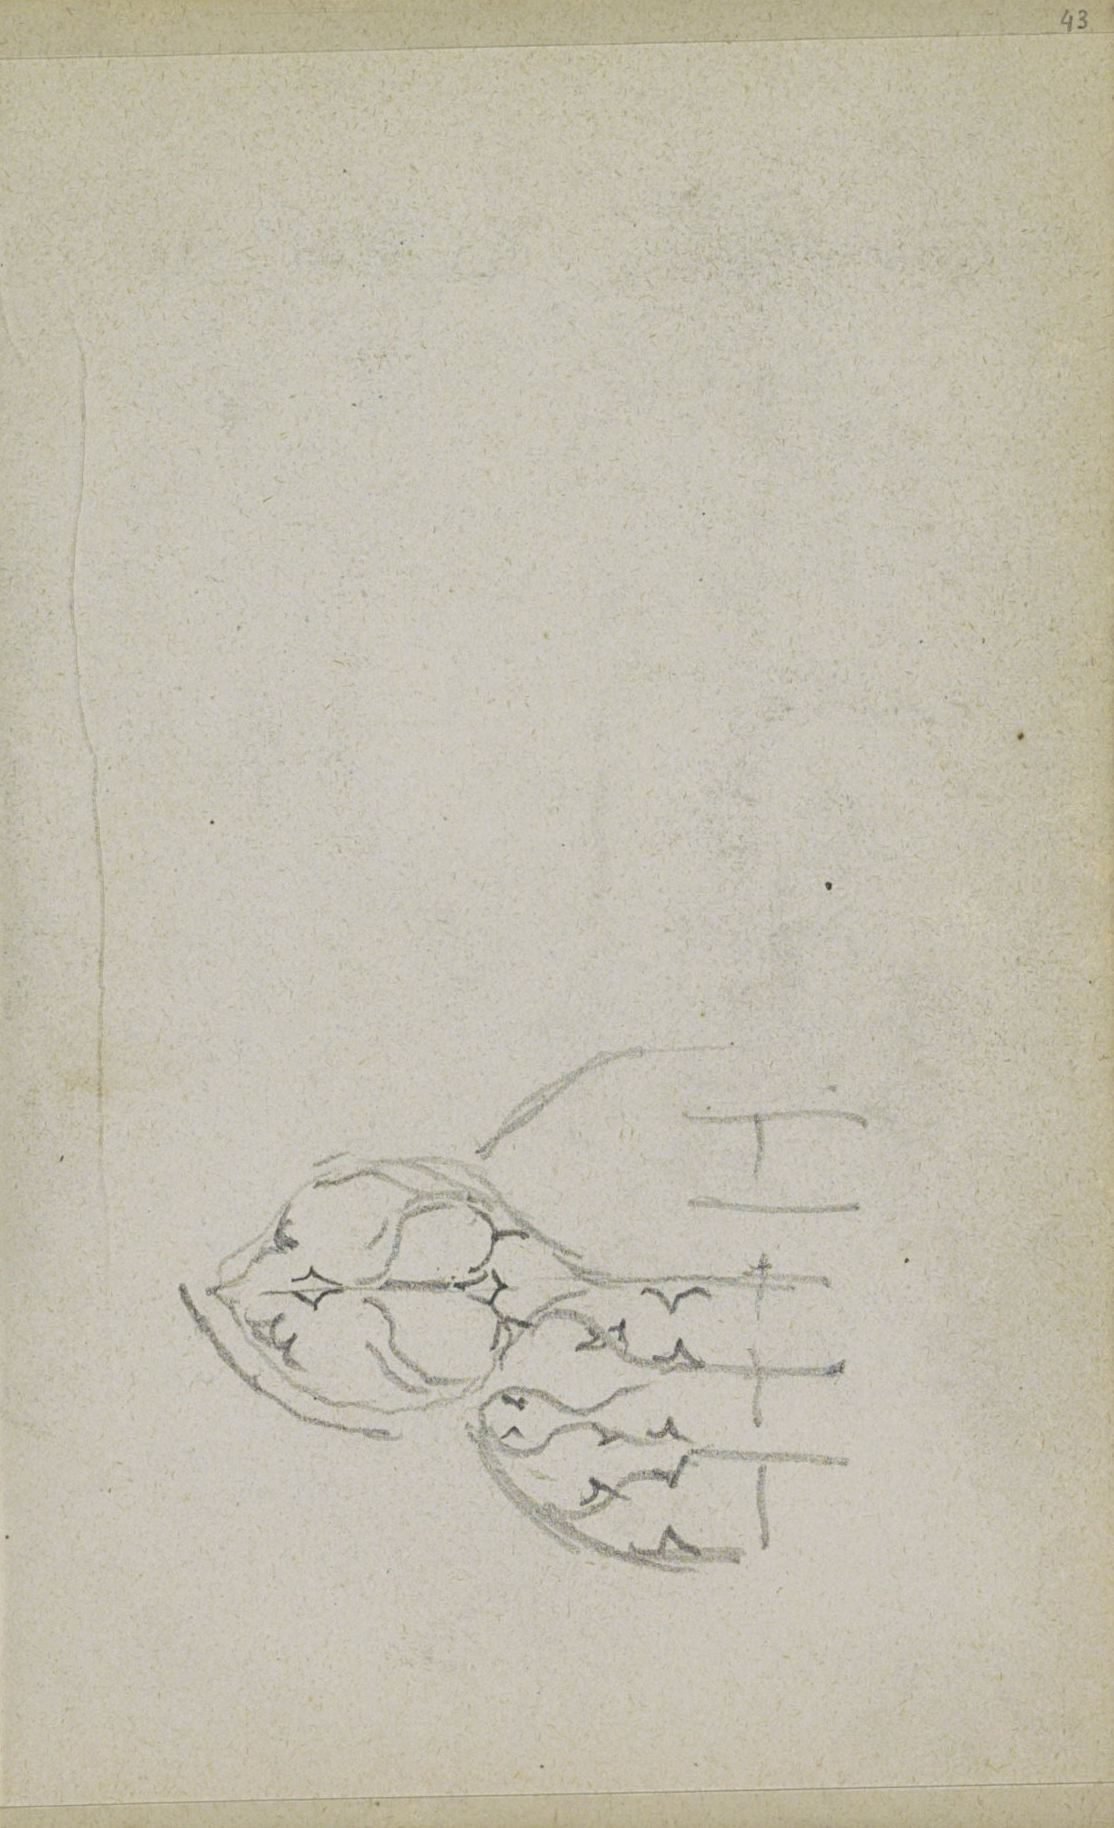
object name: sketchbook leaf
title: Studie van maaswerk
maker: adrianus eversen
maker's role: draughtsman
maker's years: 1818-1897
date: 1828-1897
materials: paper, pencil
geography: netherlands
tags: ornament ~ tracery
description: Studie van maaswerk. Blad 43 recto uit een schetsboek met 58 bladen.